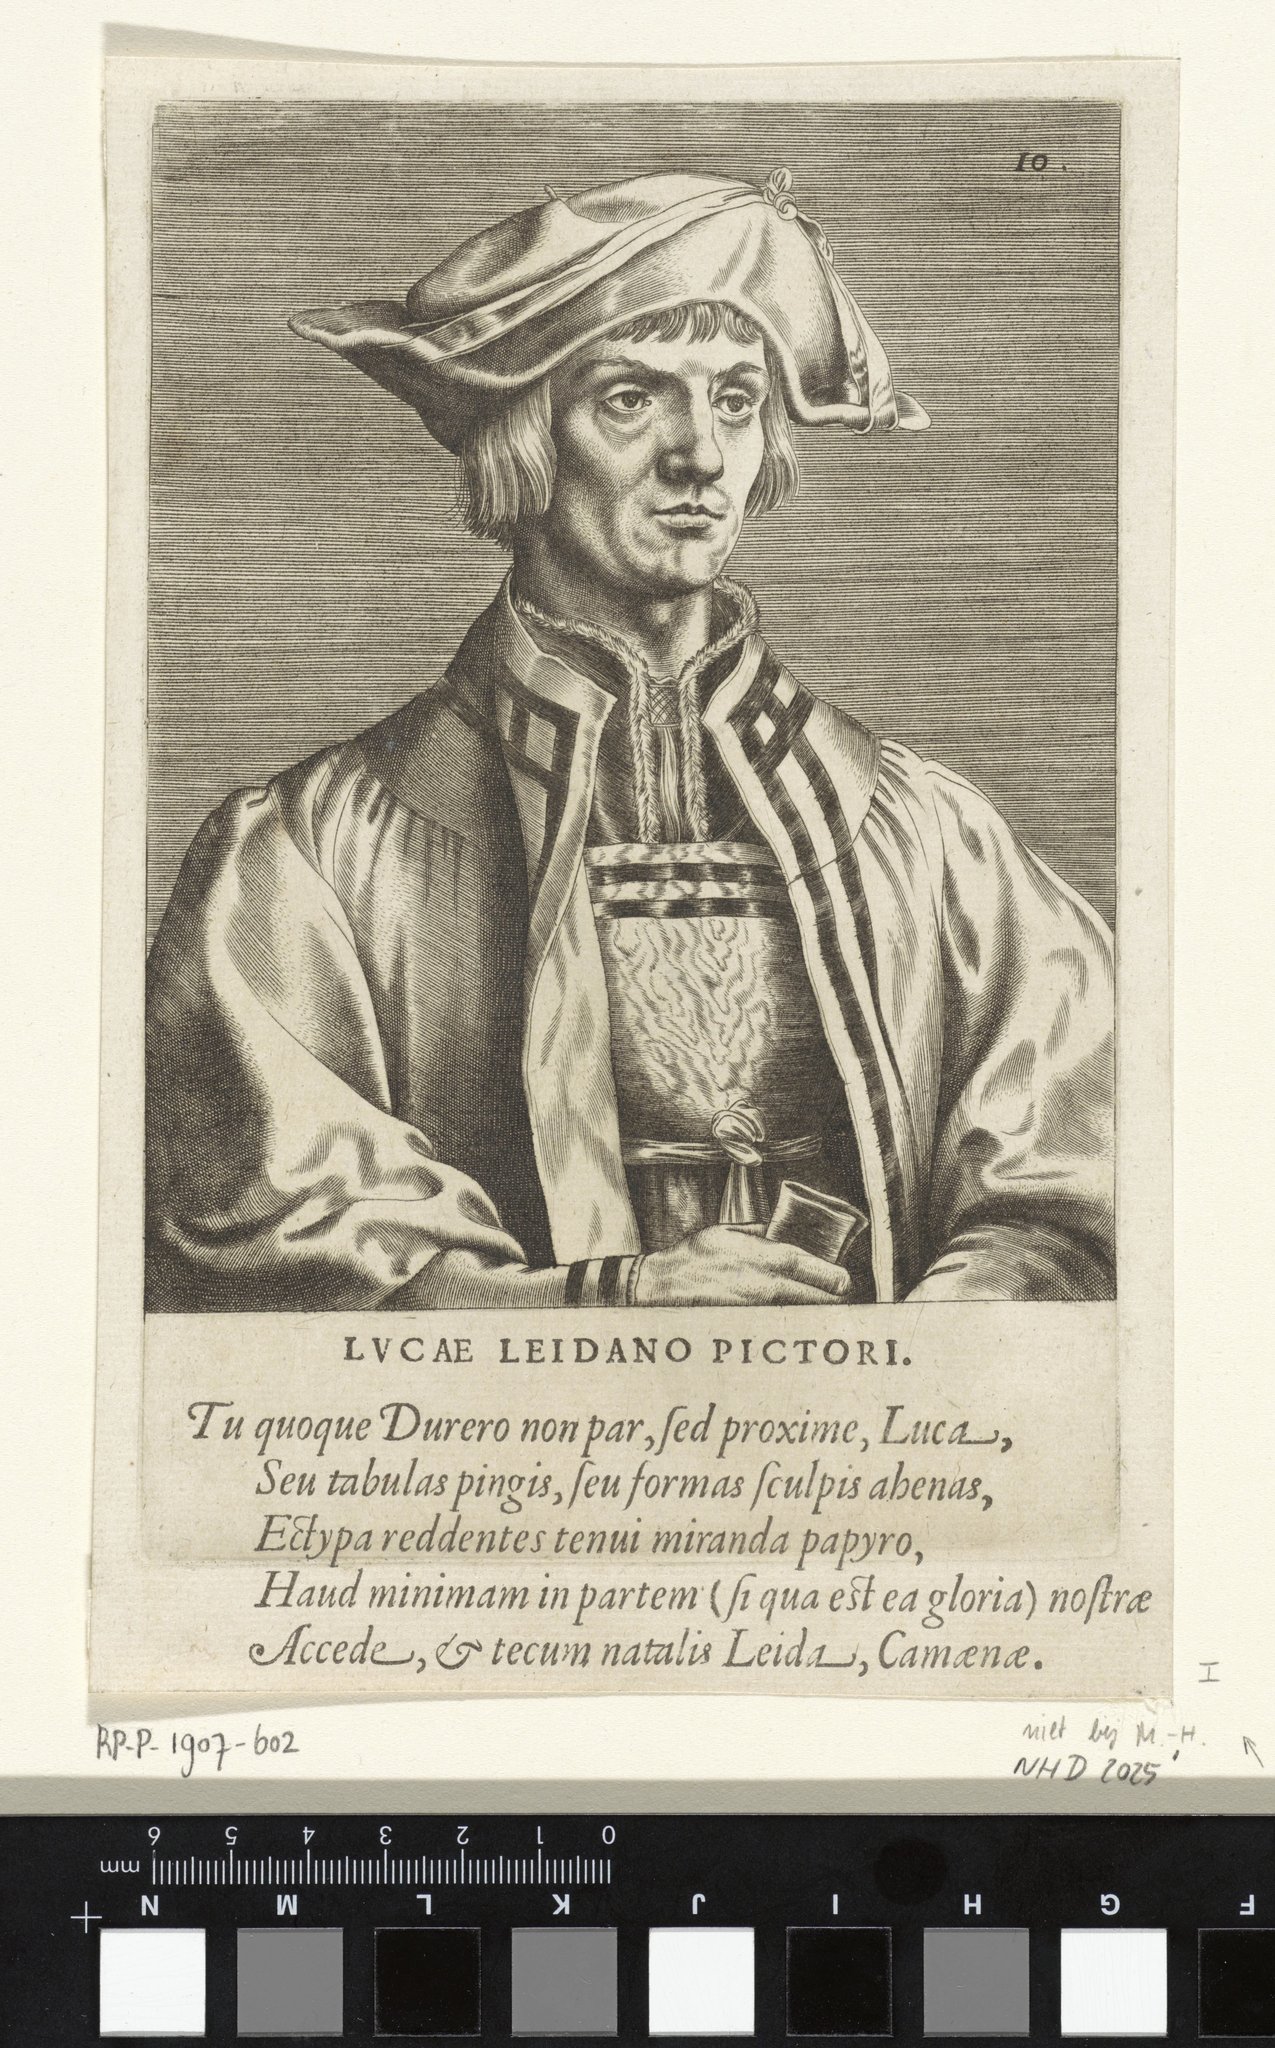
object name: print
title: Portretten van schilders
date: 1572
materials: paper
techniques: engraving, letterpress printing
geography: antwerp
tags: draughtsman, lucas van leyden, portrait, self-portrait of painter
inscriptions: collector's mark: Lugt 2228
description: In de marge een vijfregelig onderschrift in het Latijn.